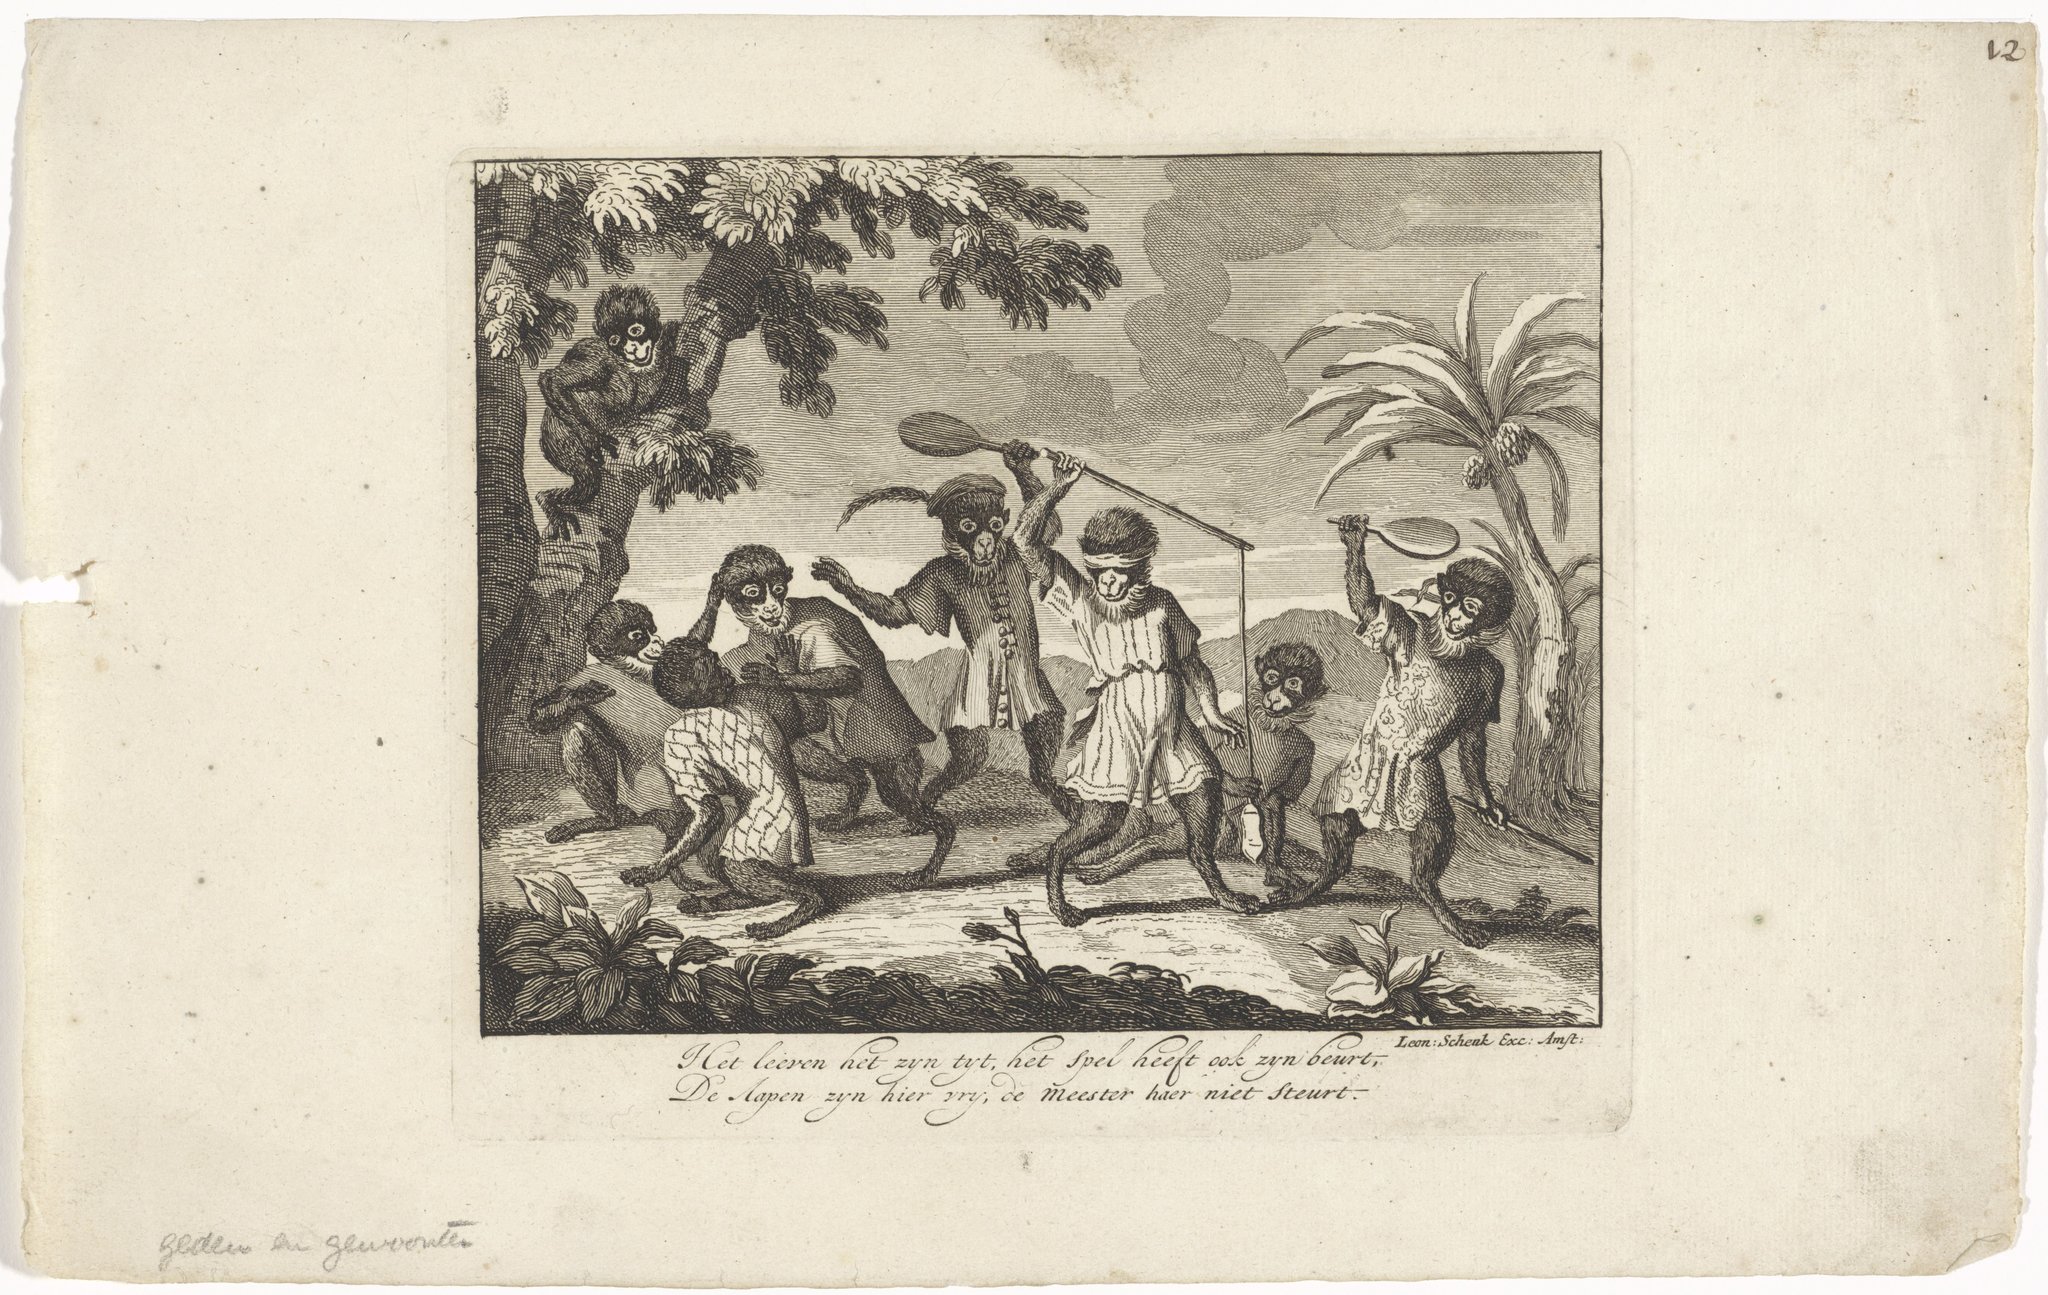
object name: print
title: Spelende apen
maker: leonard schenk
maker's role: print maker, publisher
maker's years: 1696-1767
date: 1720-1767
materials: paper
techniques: etching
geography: amsterdam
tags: fruits (with name) (+ parts of plants), monkeys, apes, animals acting as human beings, children's games and plays (+ out of doors (sports, games, etc.))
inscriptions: collector's mark: Lugt 2228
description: Jonge apen spelen buiten kinderspelletjes. Rechts staat een banenenboom. Onderdeel van een serie bestaande uit een titelprent en platen waarin apen als mensen figureren in allerlei taferelen uit het dagelijks leven. De prent heeft een tweeregelig vers in het Nederlands.